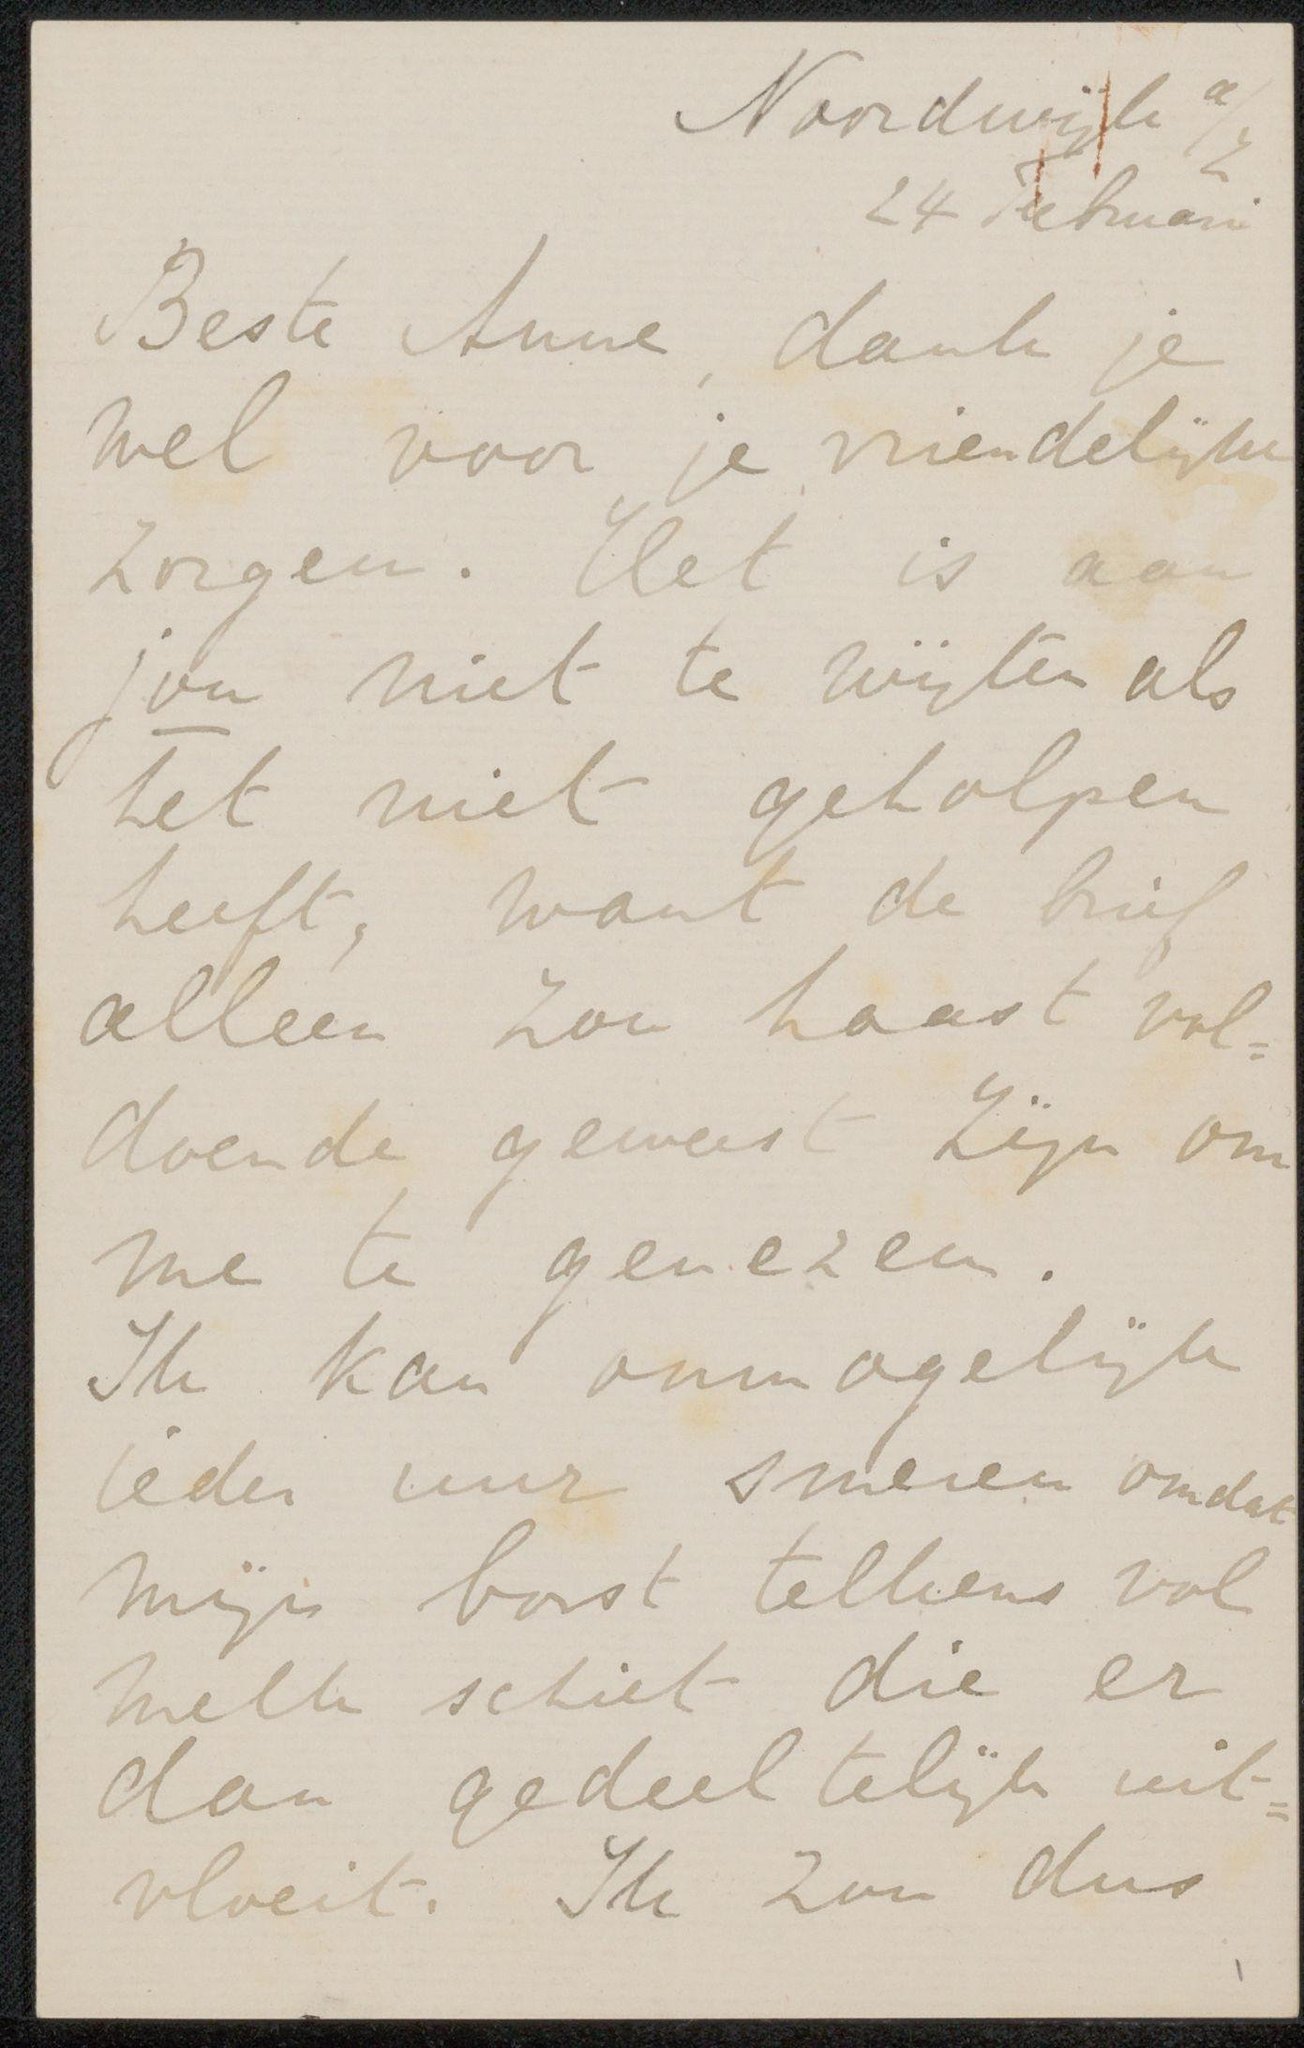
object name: letter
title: Brief aan Anna Dorothea Dirks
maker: kitty van vloten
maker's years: 1867-1945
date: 1887-1929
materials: ink, paper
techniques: pen, writing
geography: noordwijk aan zee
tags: dordrecht, painter, draughtsman, designer, jan veth, amsterdam, albert verwey, artist, anna dorothea dirks, saskia delprat-veth, family life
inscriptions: collector's mark: ‘RPK’